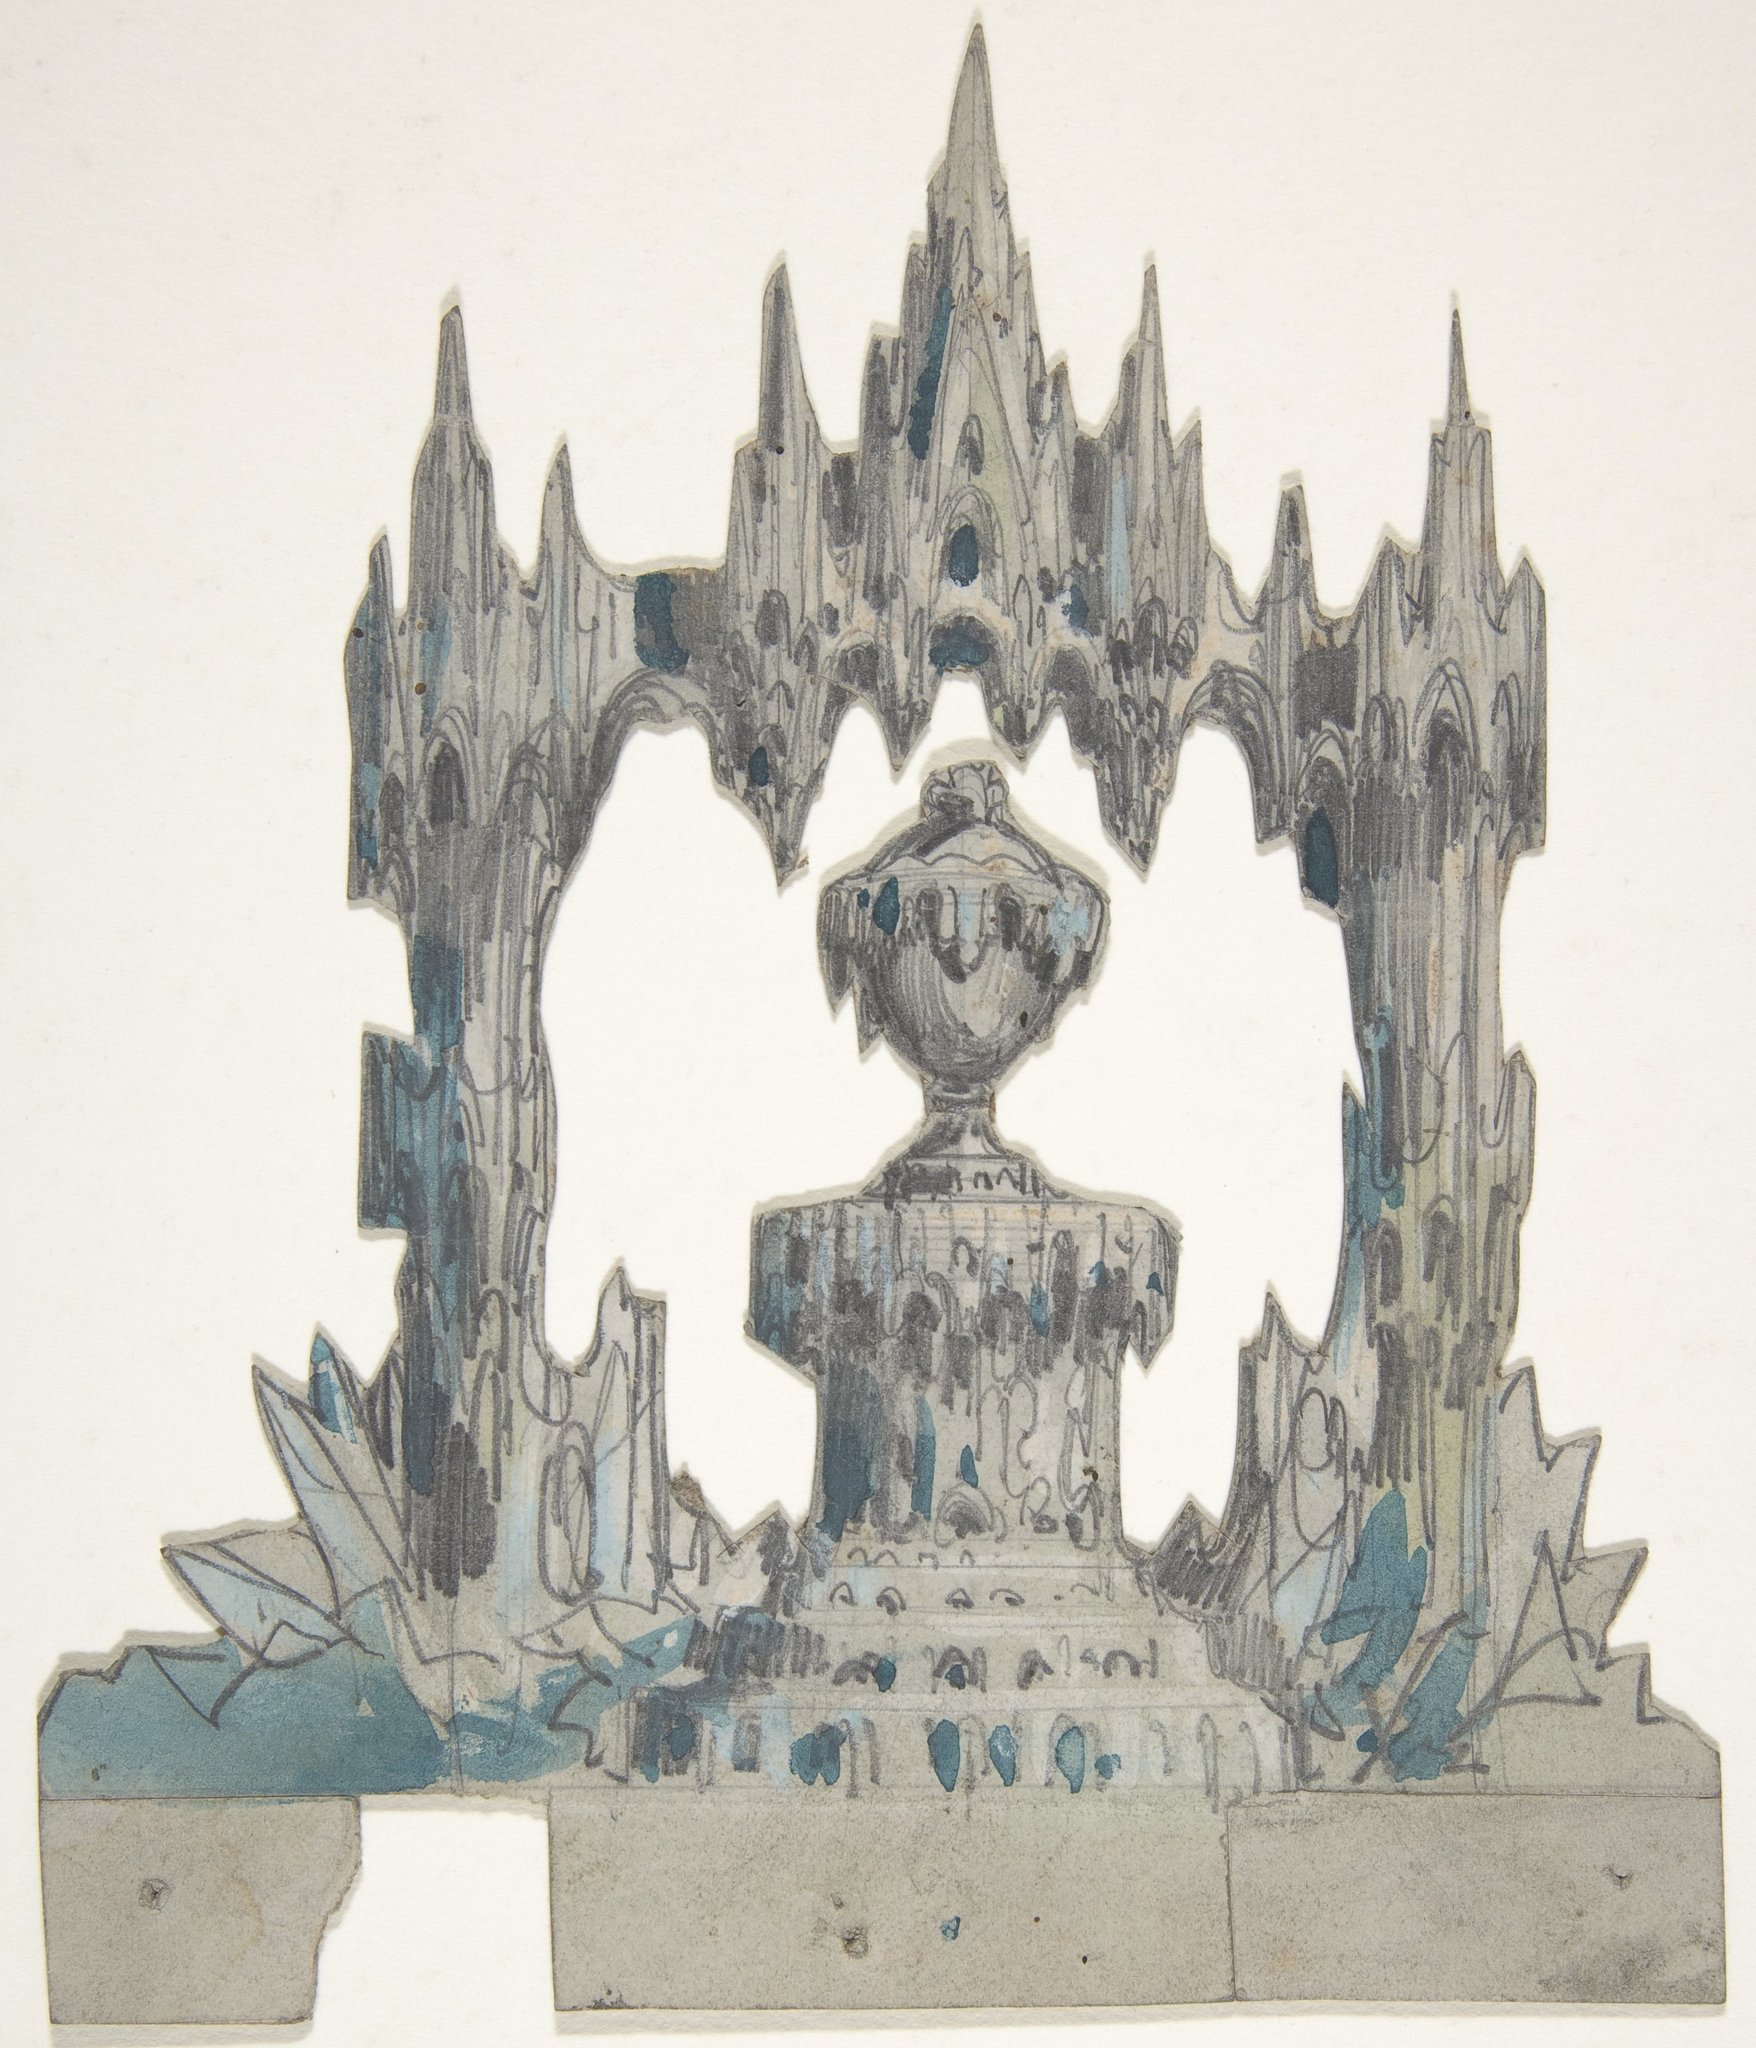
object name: drawing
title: Design for a Stage Set at the Opéra, Paris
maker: eugène cicéri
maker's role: artist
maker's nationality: french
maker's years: 1813-1890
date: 1830-1890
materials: graphite, watercolor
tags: stage design